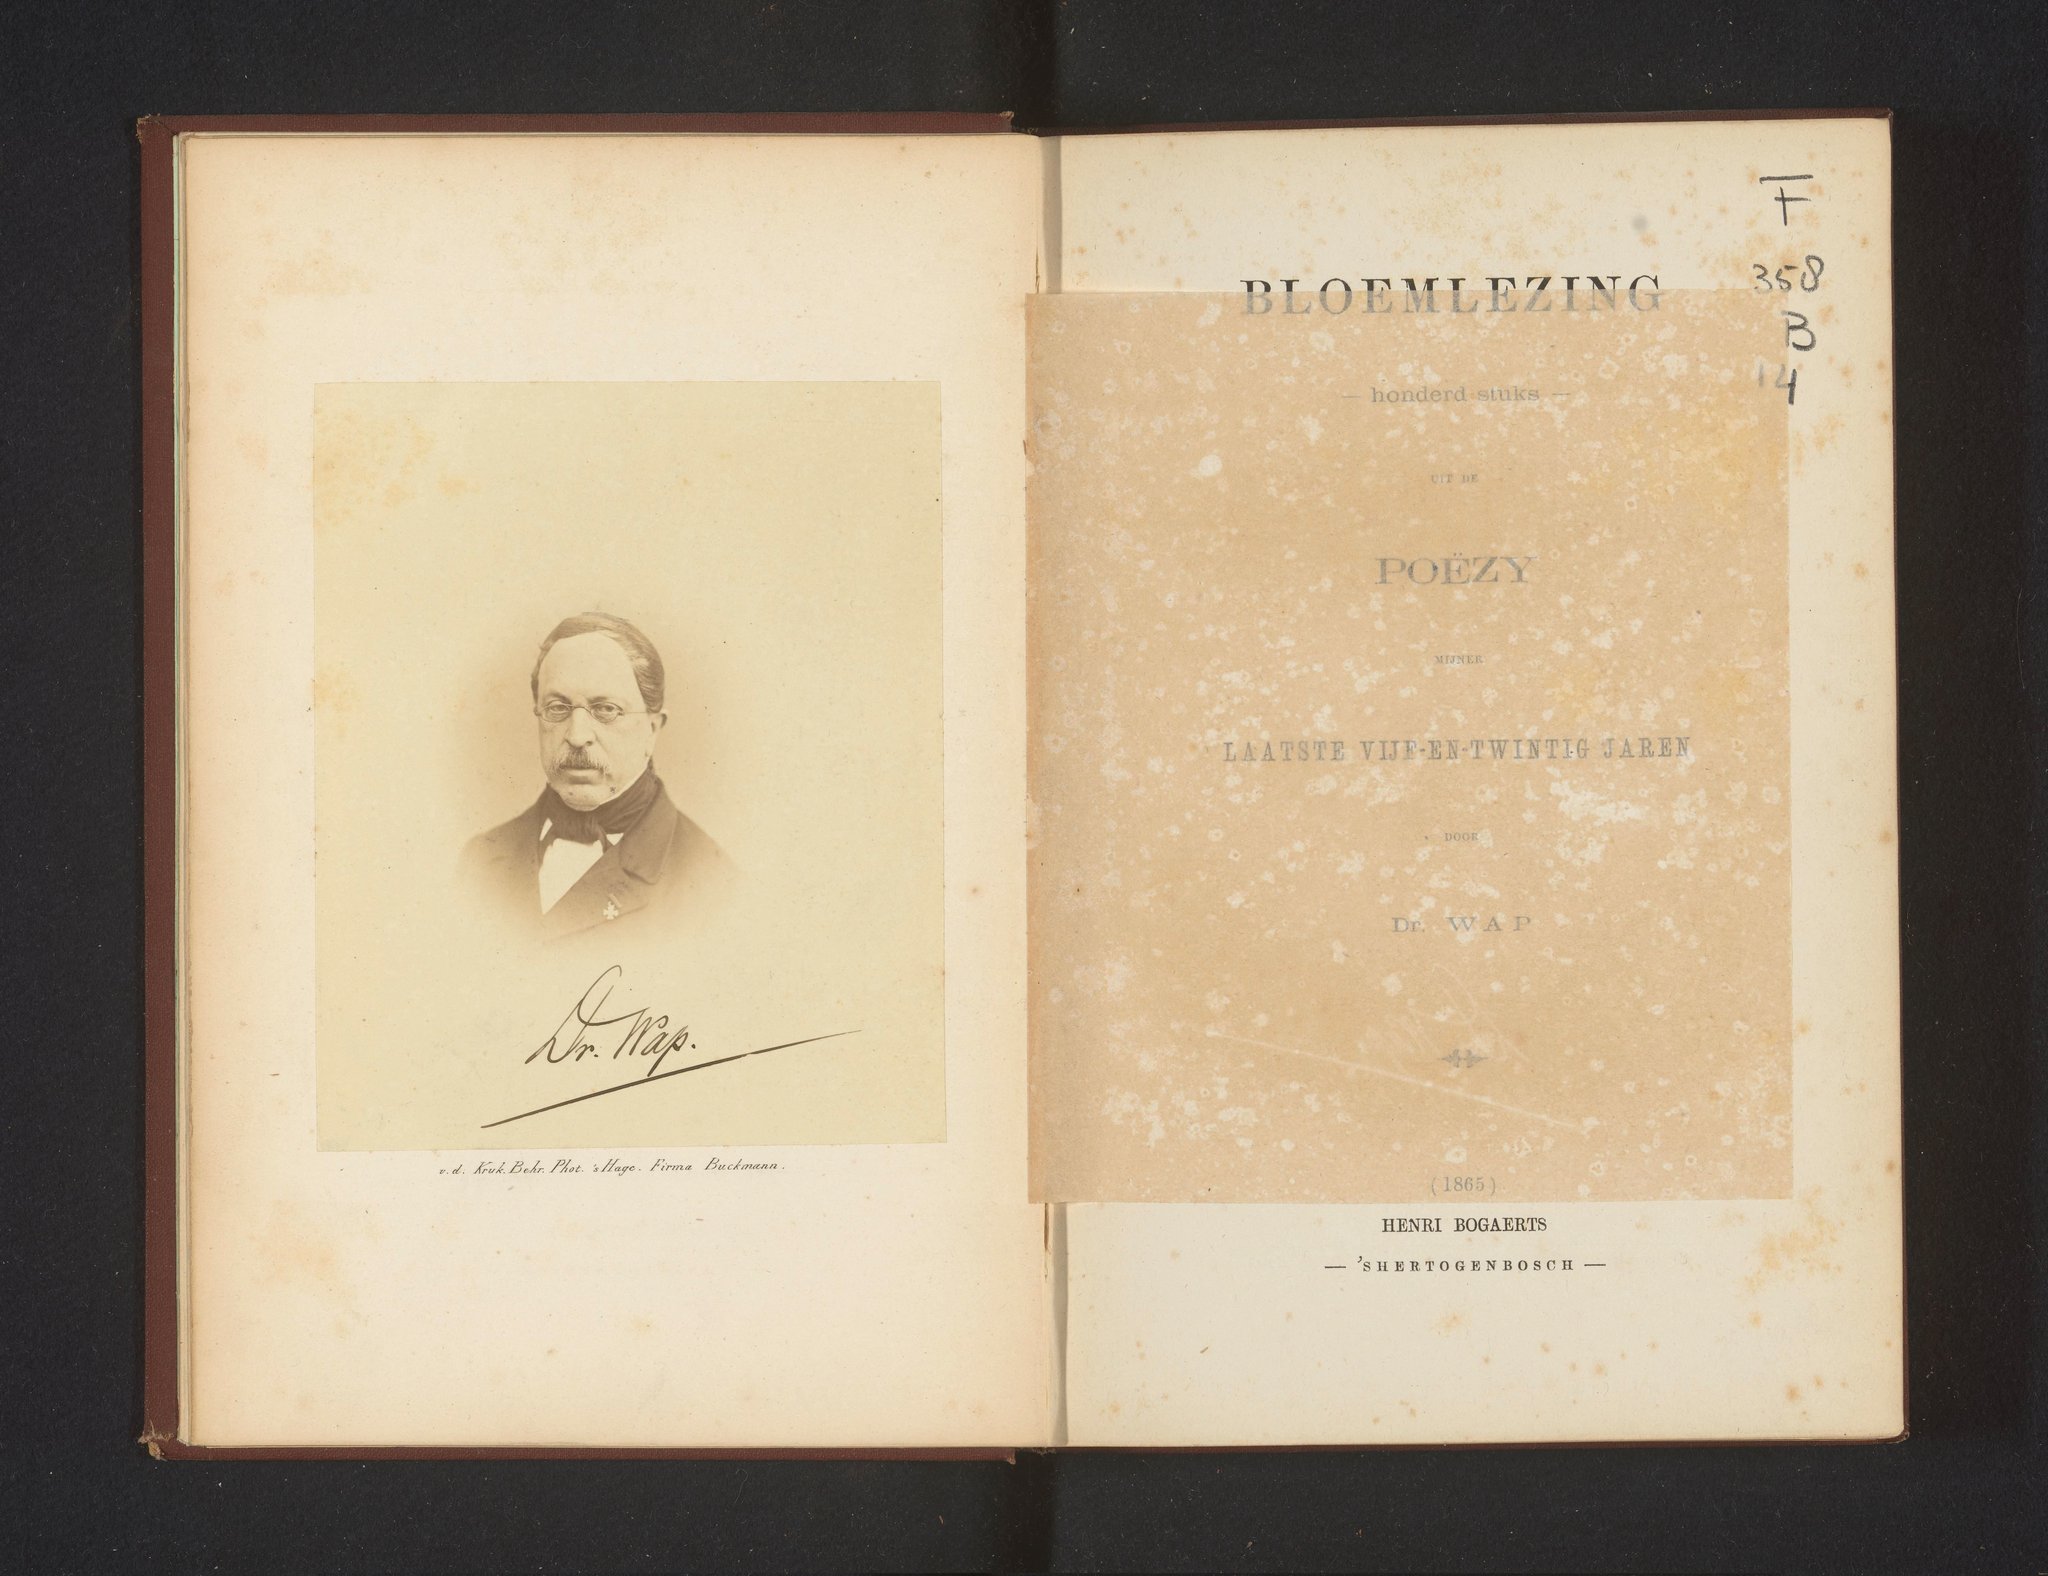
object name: page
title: Dr. Wap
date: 1897-1902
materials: photographic support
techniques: albumen print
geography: the hague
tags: johannes jacobus franciscus wap, historical persons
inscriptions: name: ‘v.d. Kruk. Behr. Phot. 's Hage. Firma Buckmann.’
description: Foto tegenover titelpagina, achter semi-transparante omslag.